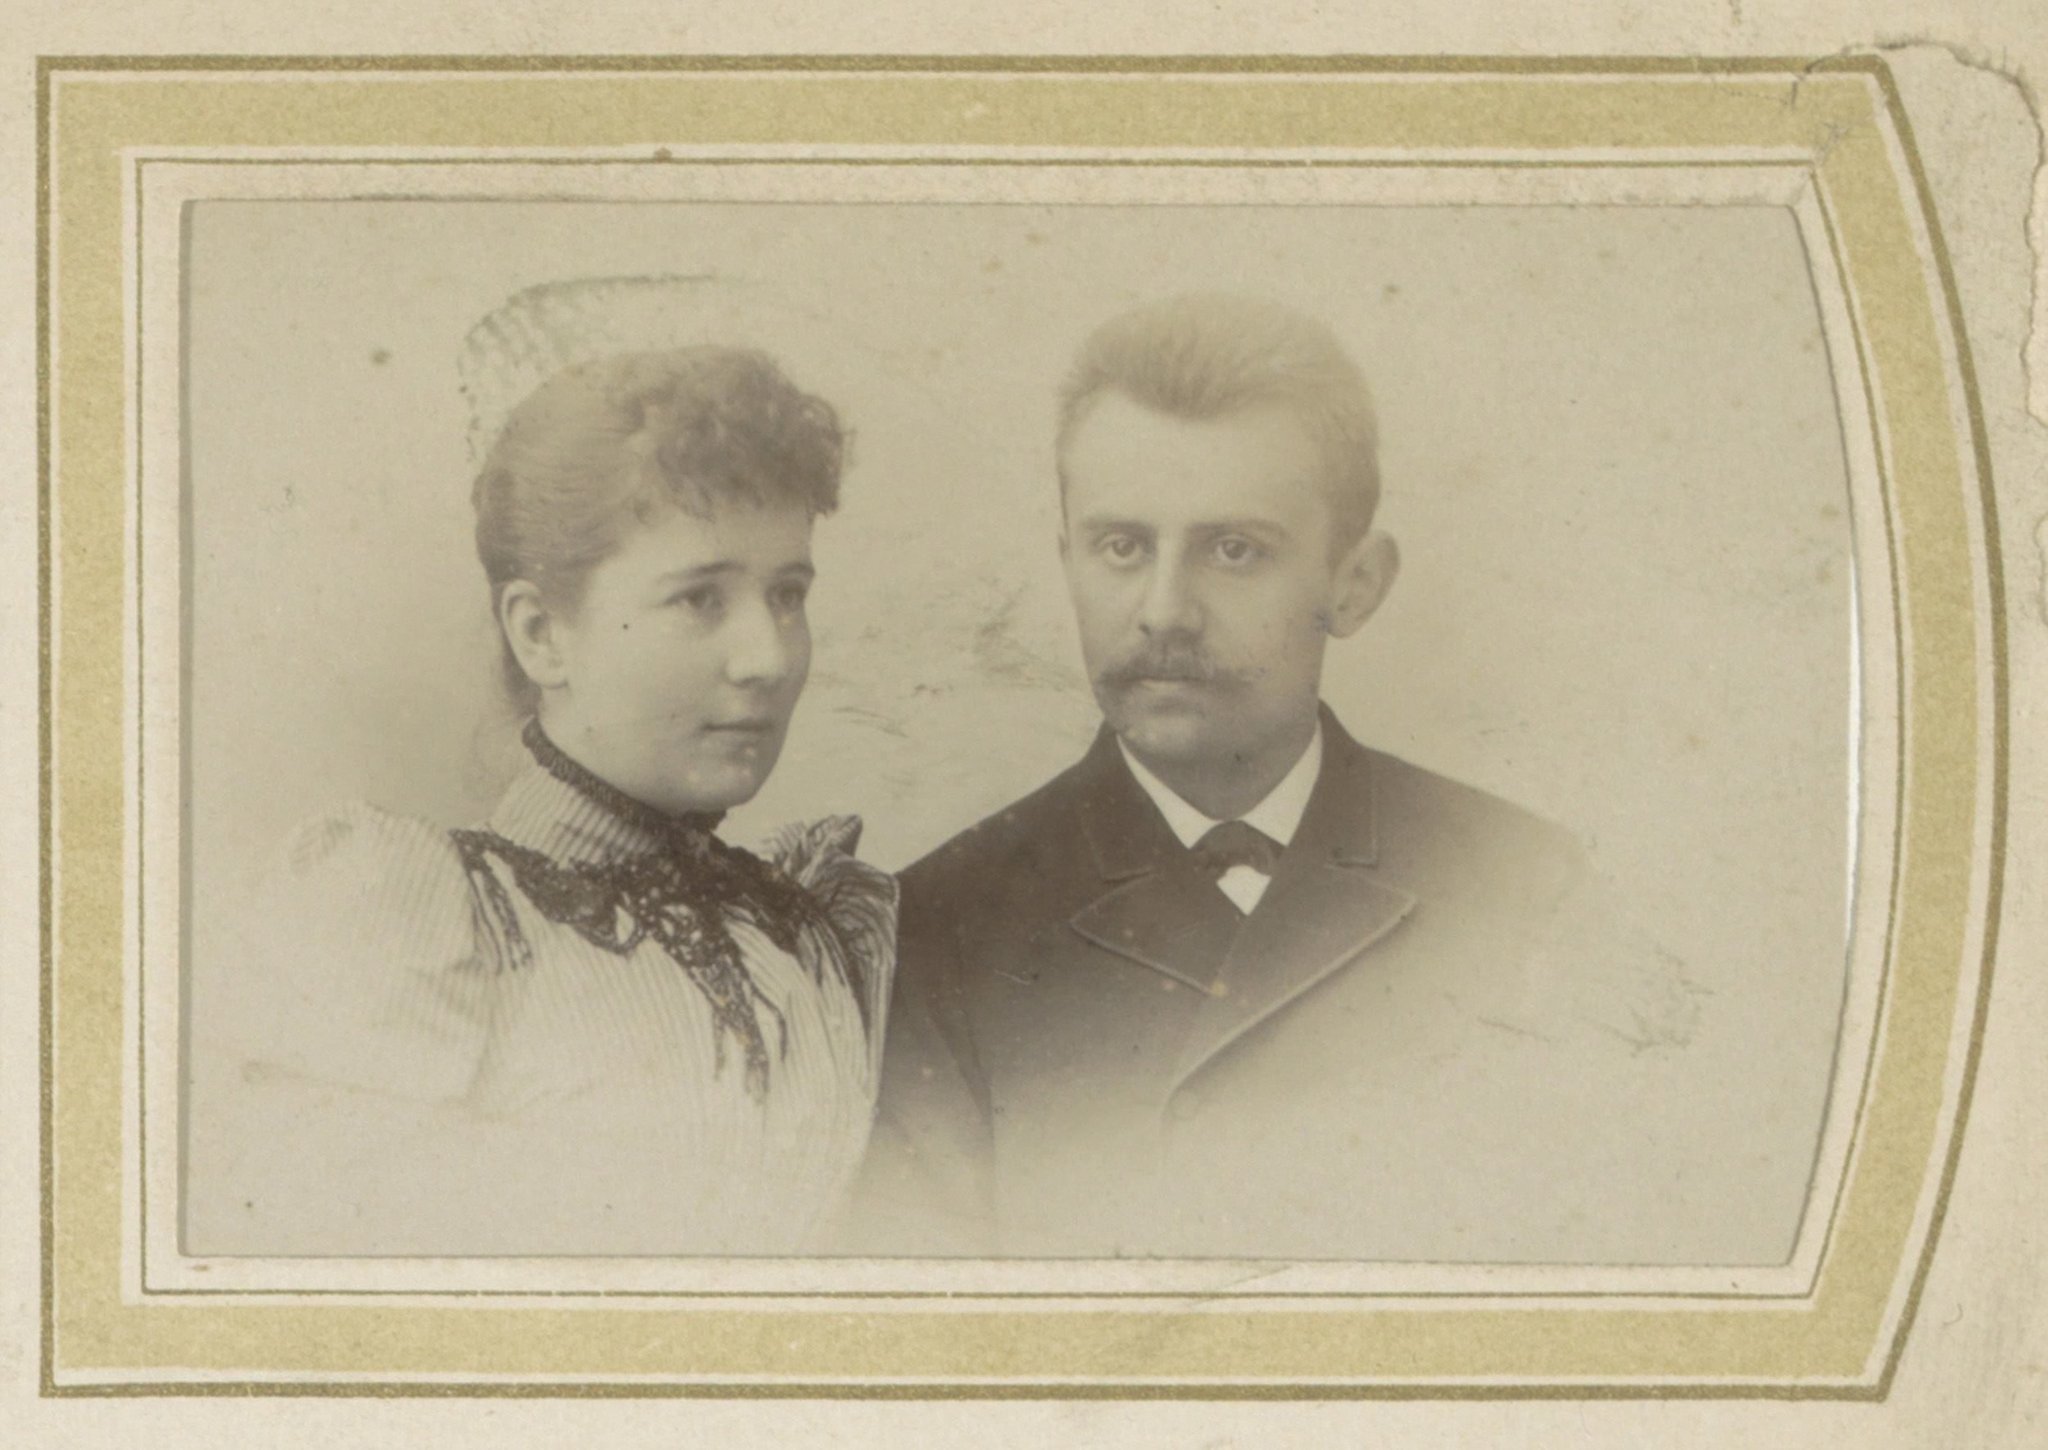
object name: photograph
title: Portret van een vrouw met een versierde jurk en een man met een snor en een das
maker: Anonymous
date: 1860-1900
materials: cardboard, paper, photographic support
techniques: albumen print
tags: moustache, historical persons, styles of hairdress - aa - ~ women, neck-gear ~ clothing, clothing for the upper part of the body, hairdress, coat, cape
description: Onderdeel van Fotoalbum van een Nederlandse familie met 168 cartes-de-visite en kabinetfoto's.